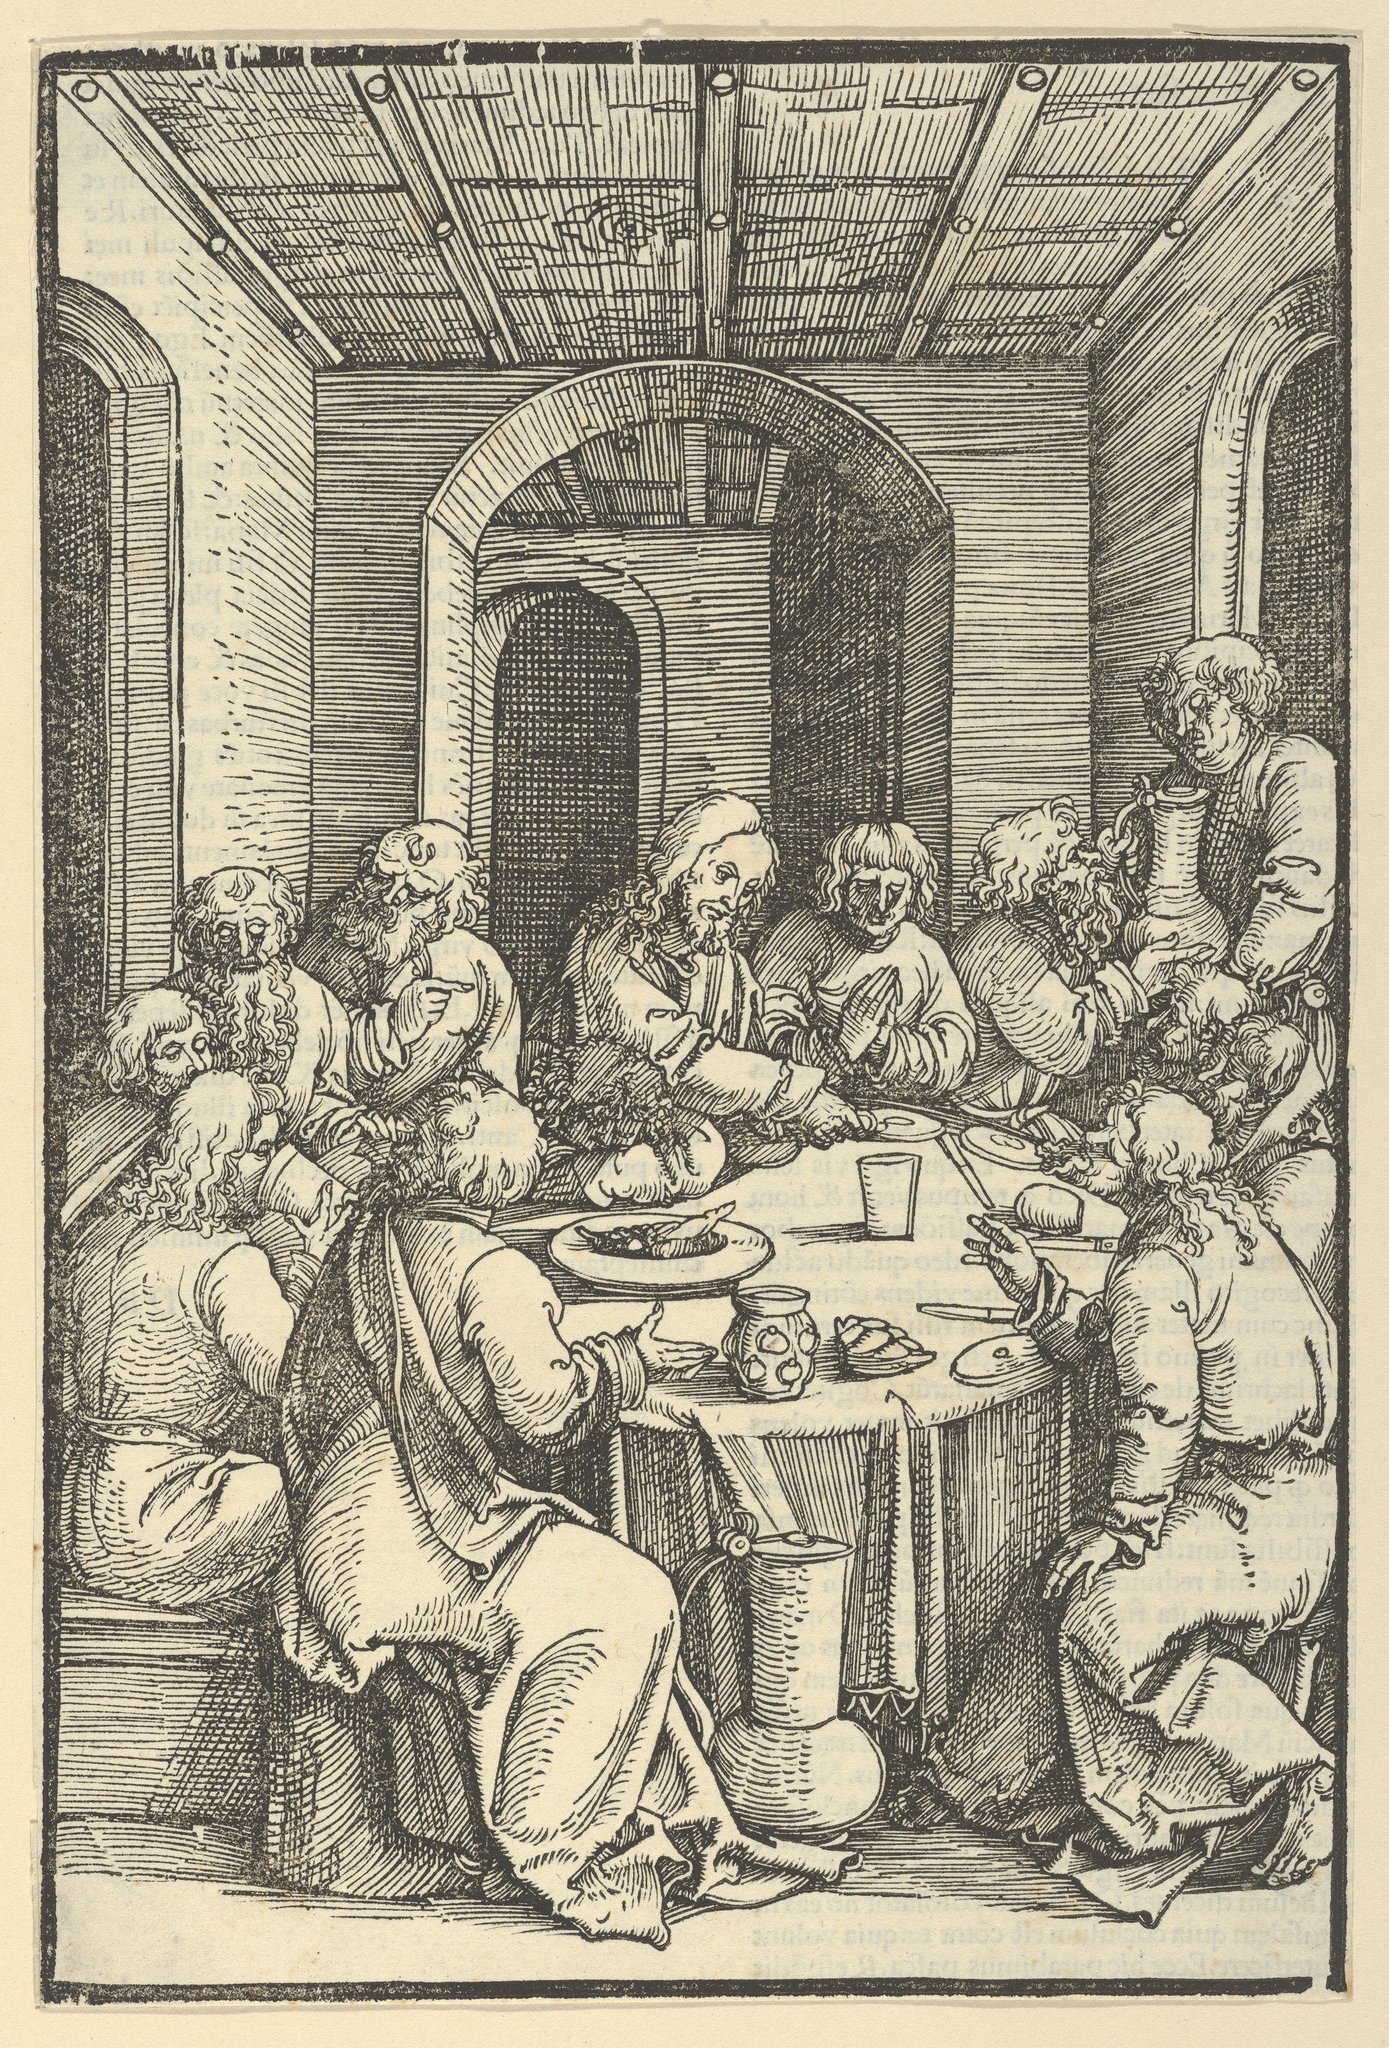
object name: print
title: The Last Supper, from Speculum passionis domini nostri Ihesu Christi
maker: hans schäufelein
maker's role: artist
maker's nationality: german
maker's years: 1480-1540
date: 1507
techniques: woodcut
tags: apostles,jesus,last supper